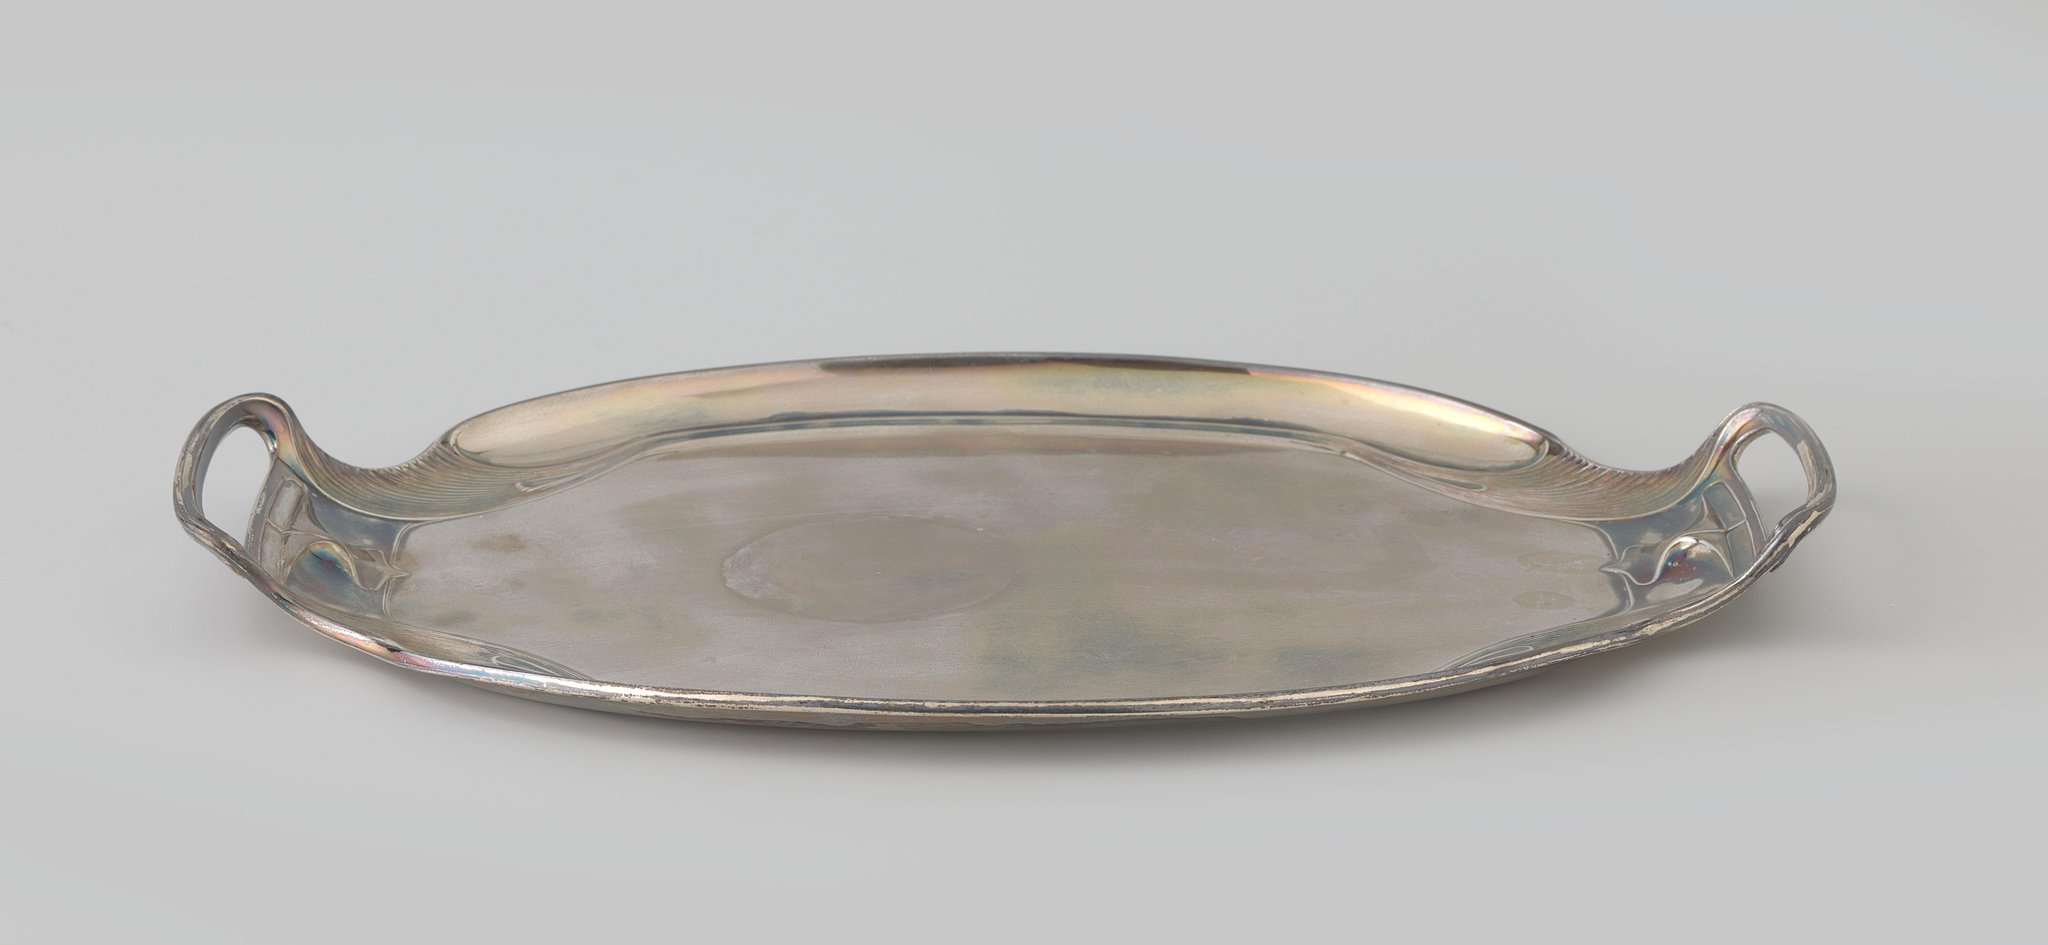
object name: salver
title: Presenteerblad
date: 1905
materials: silver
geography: germany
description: Presenteerblad van zilver, ovaal met naar buiten gewelfde opstaande rand en uitzwenkende, hoge handvatten.